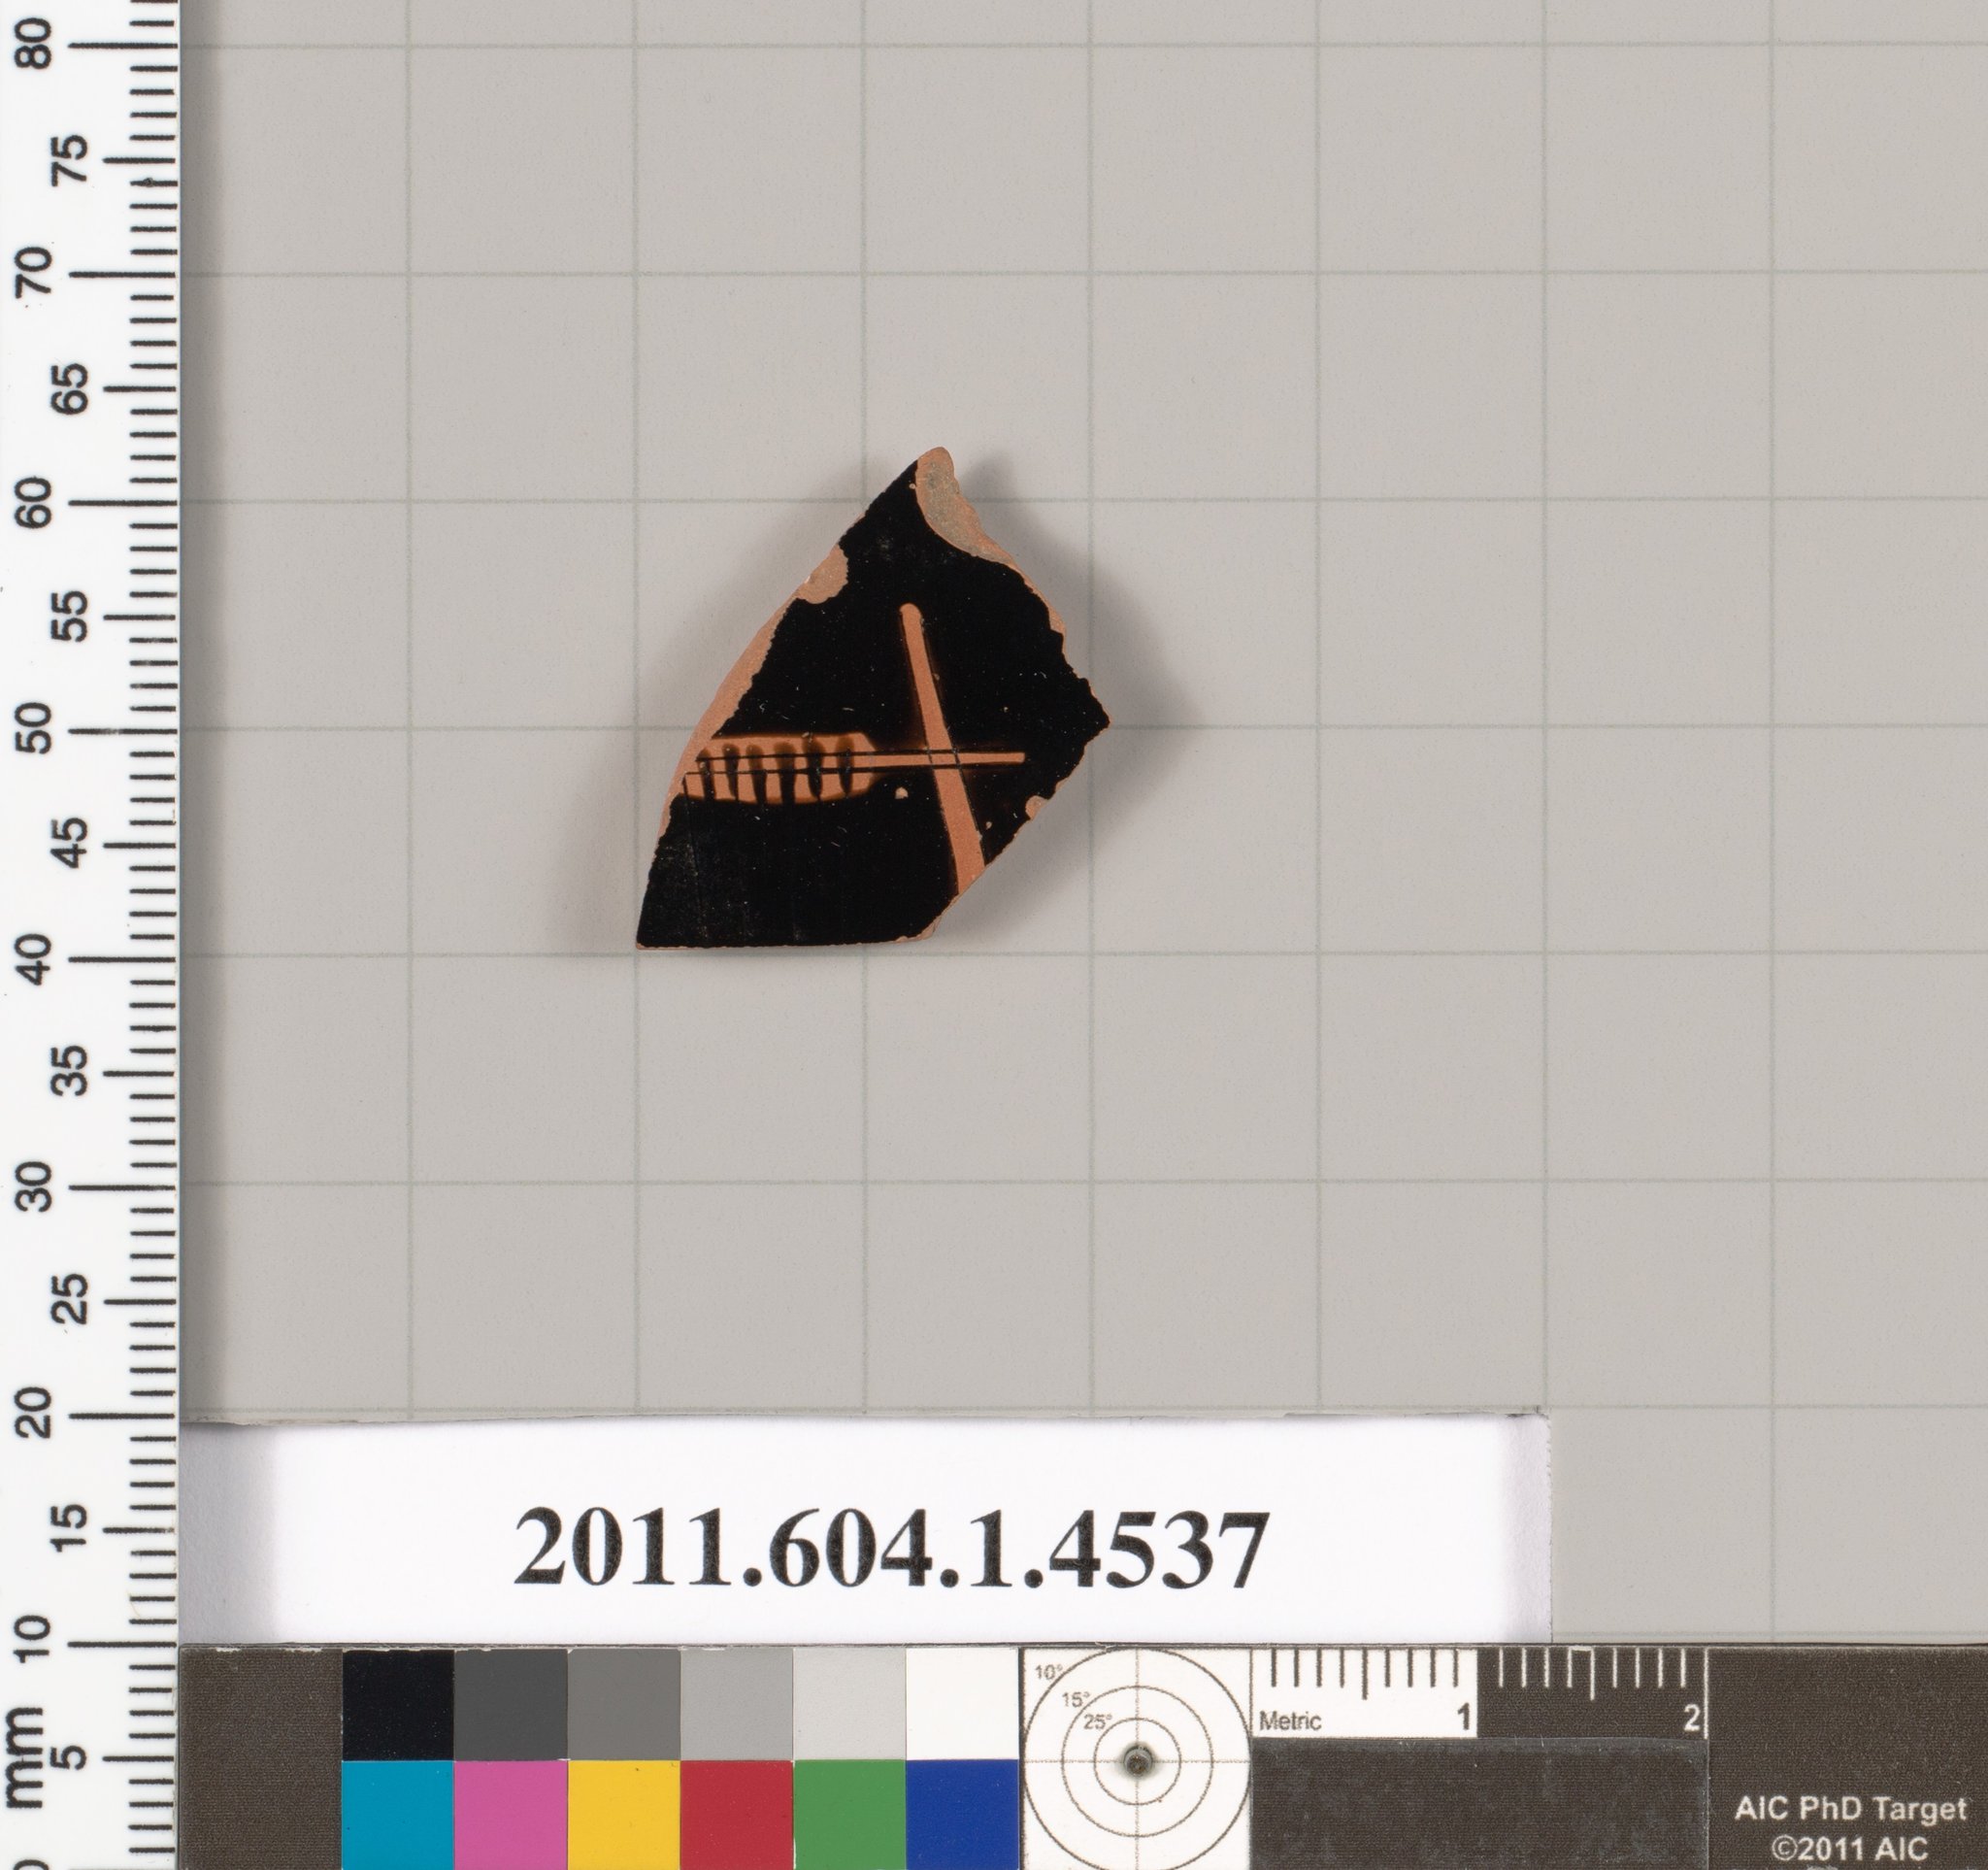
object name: kylix fragment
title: Terracotta fragment of a kylix (drinking cup)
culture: greek, attic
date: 475-451 BCE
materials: terracotta